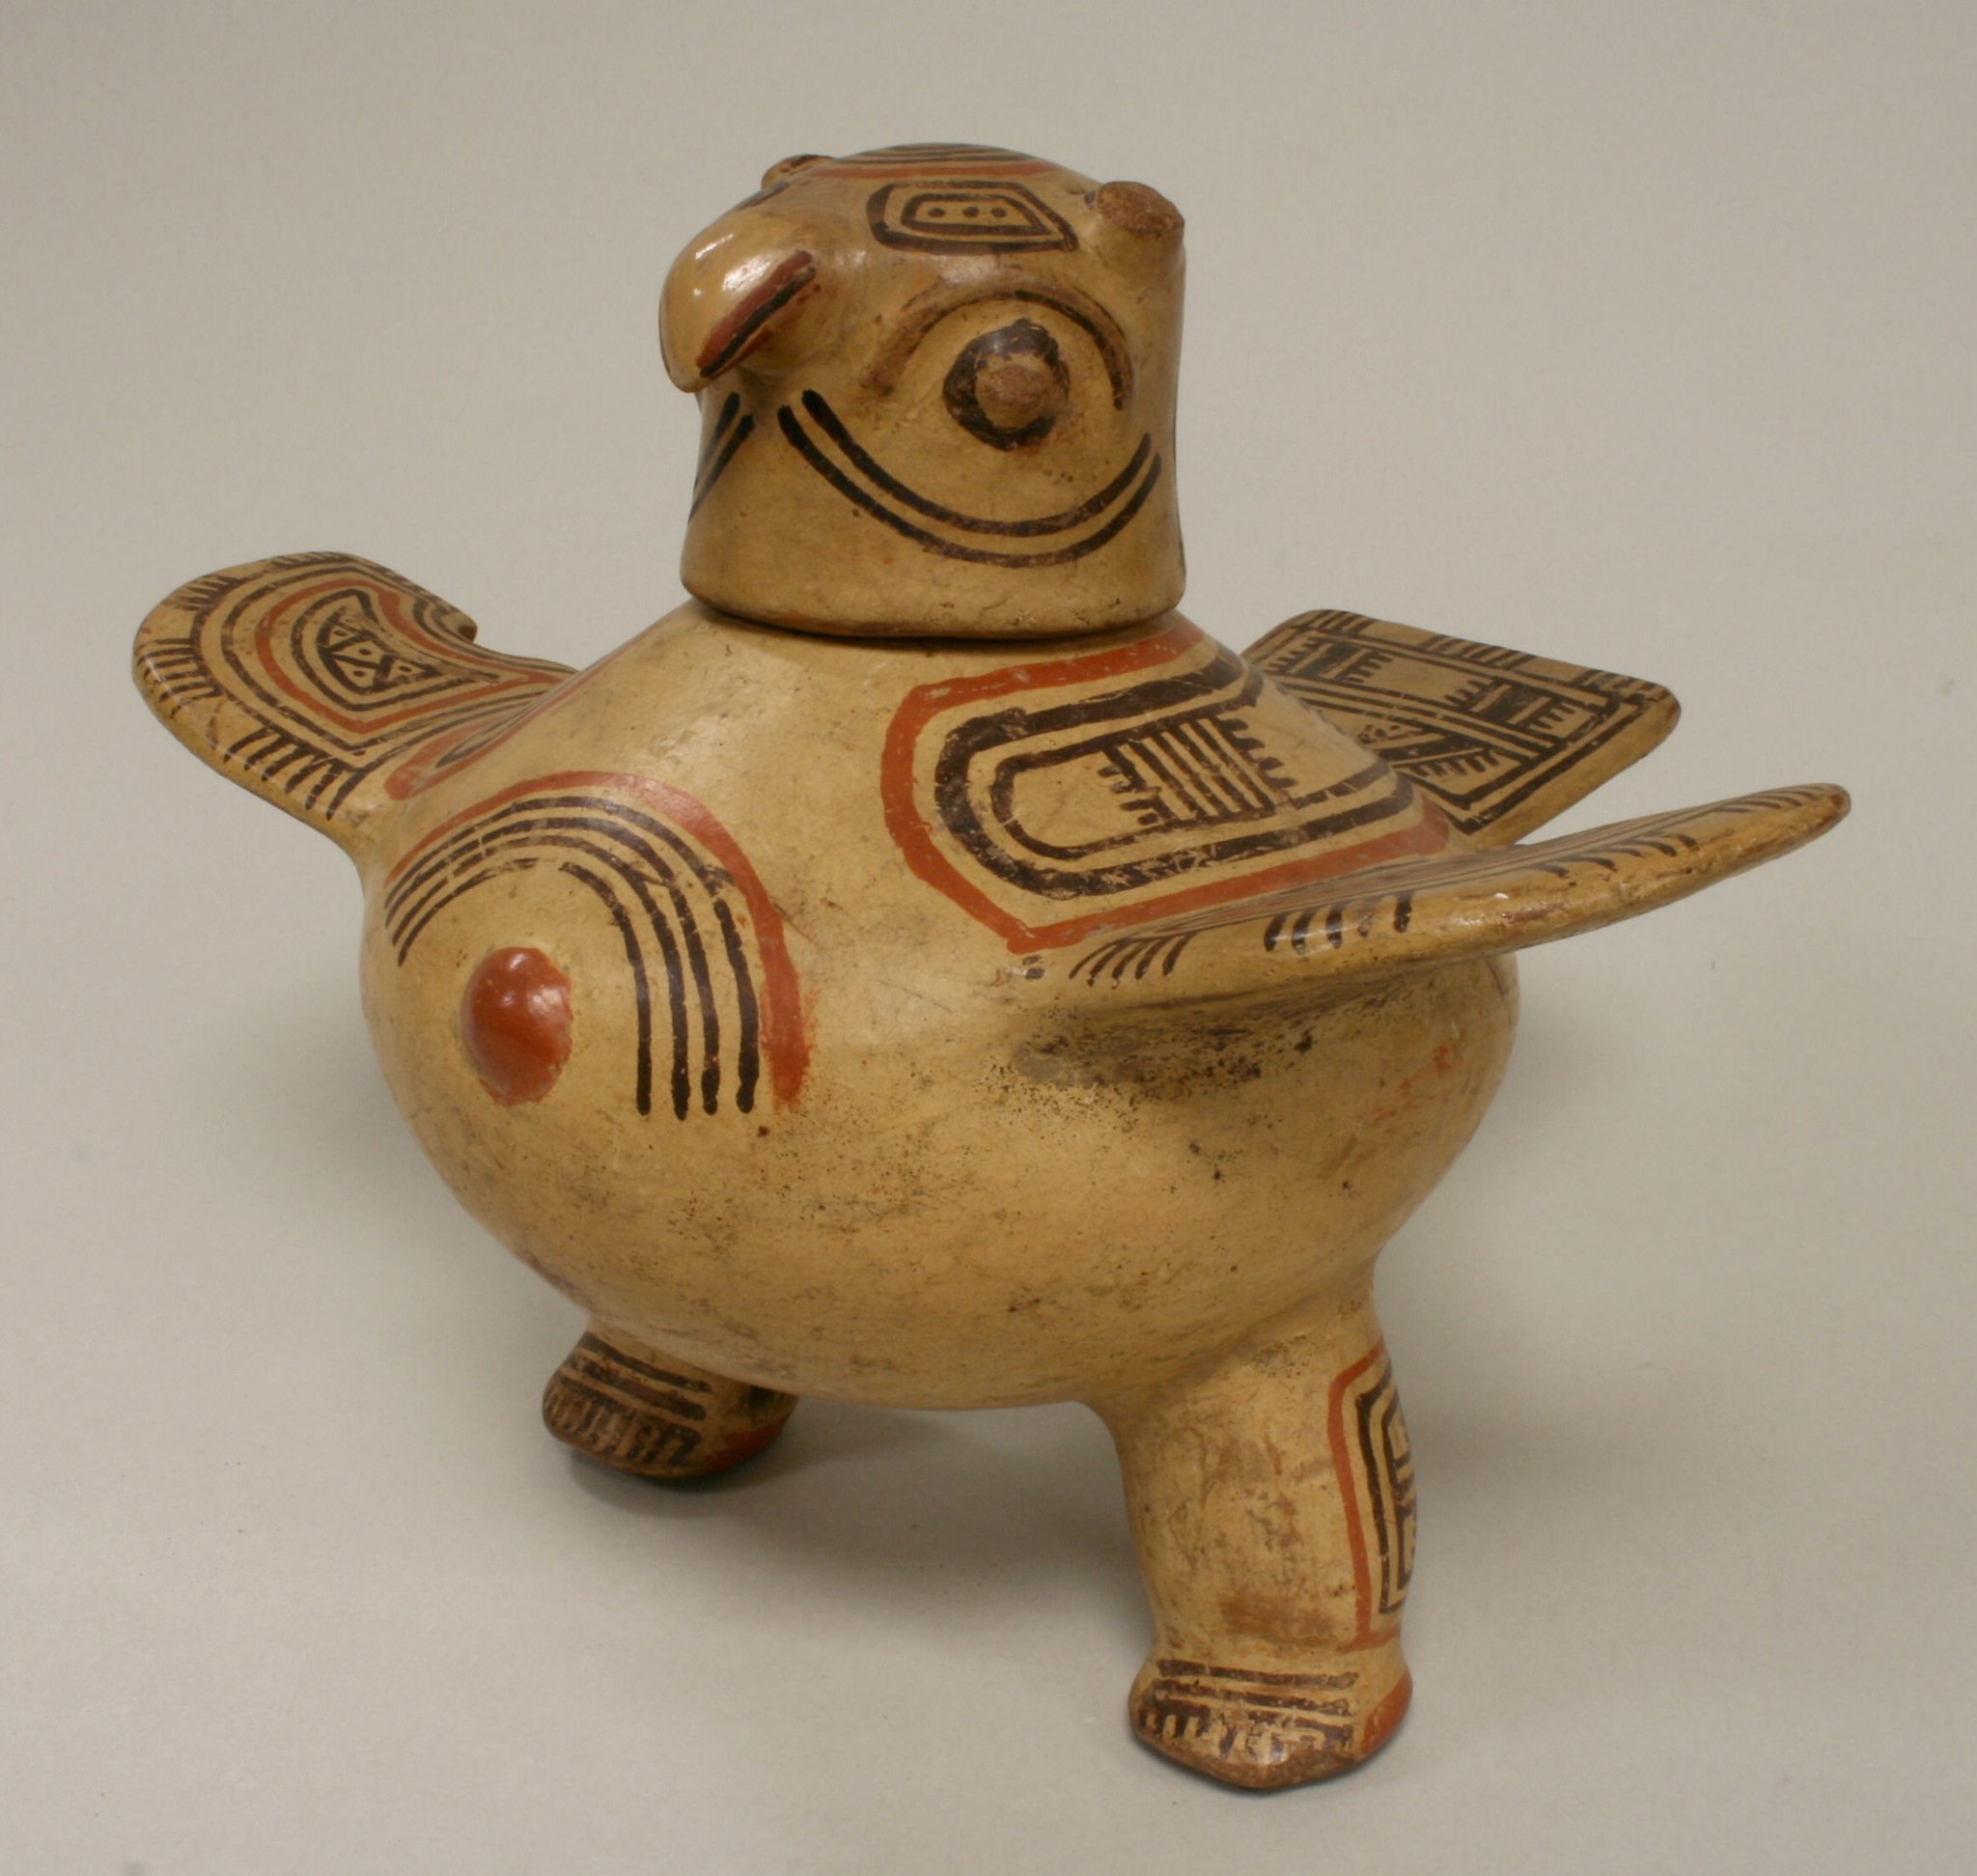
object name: vessel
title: Owl Vessel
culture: diquís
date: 501-1400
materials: ceramic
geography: costa rica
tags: owls